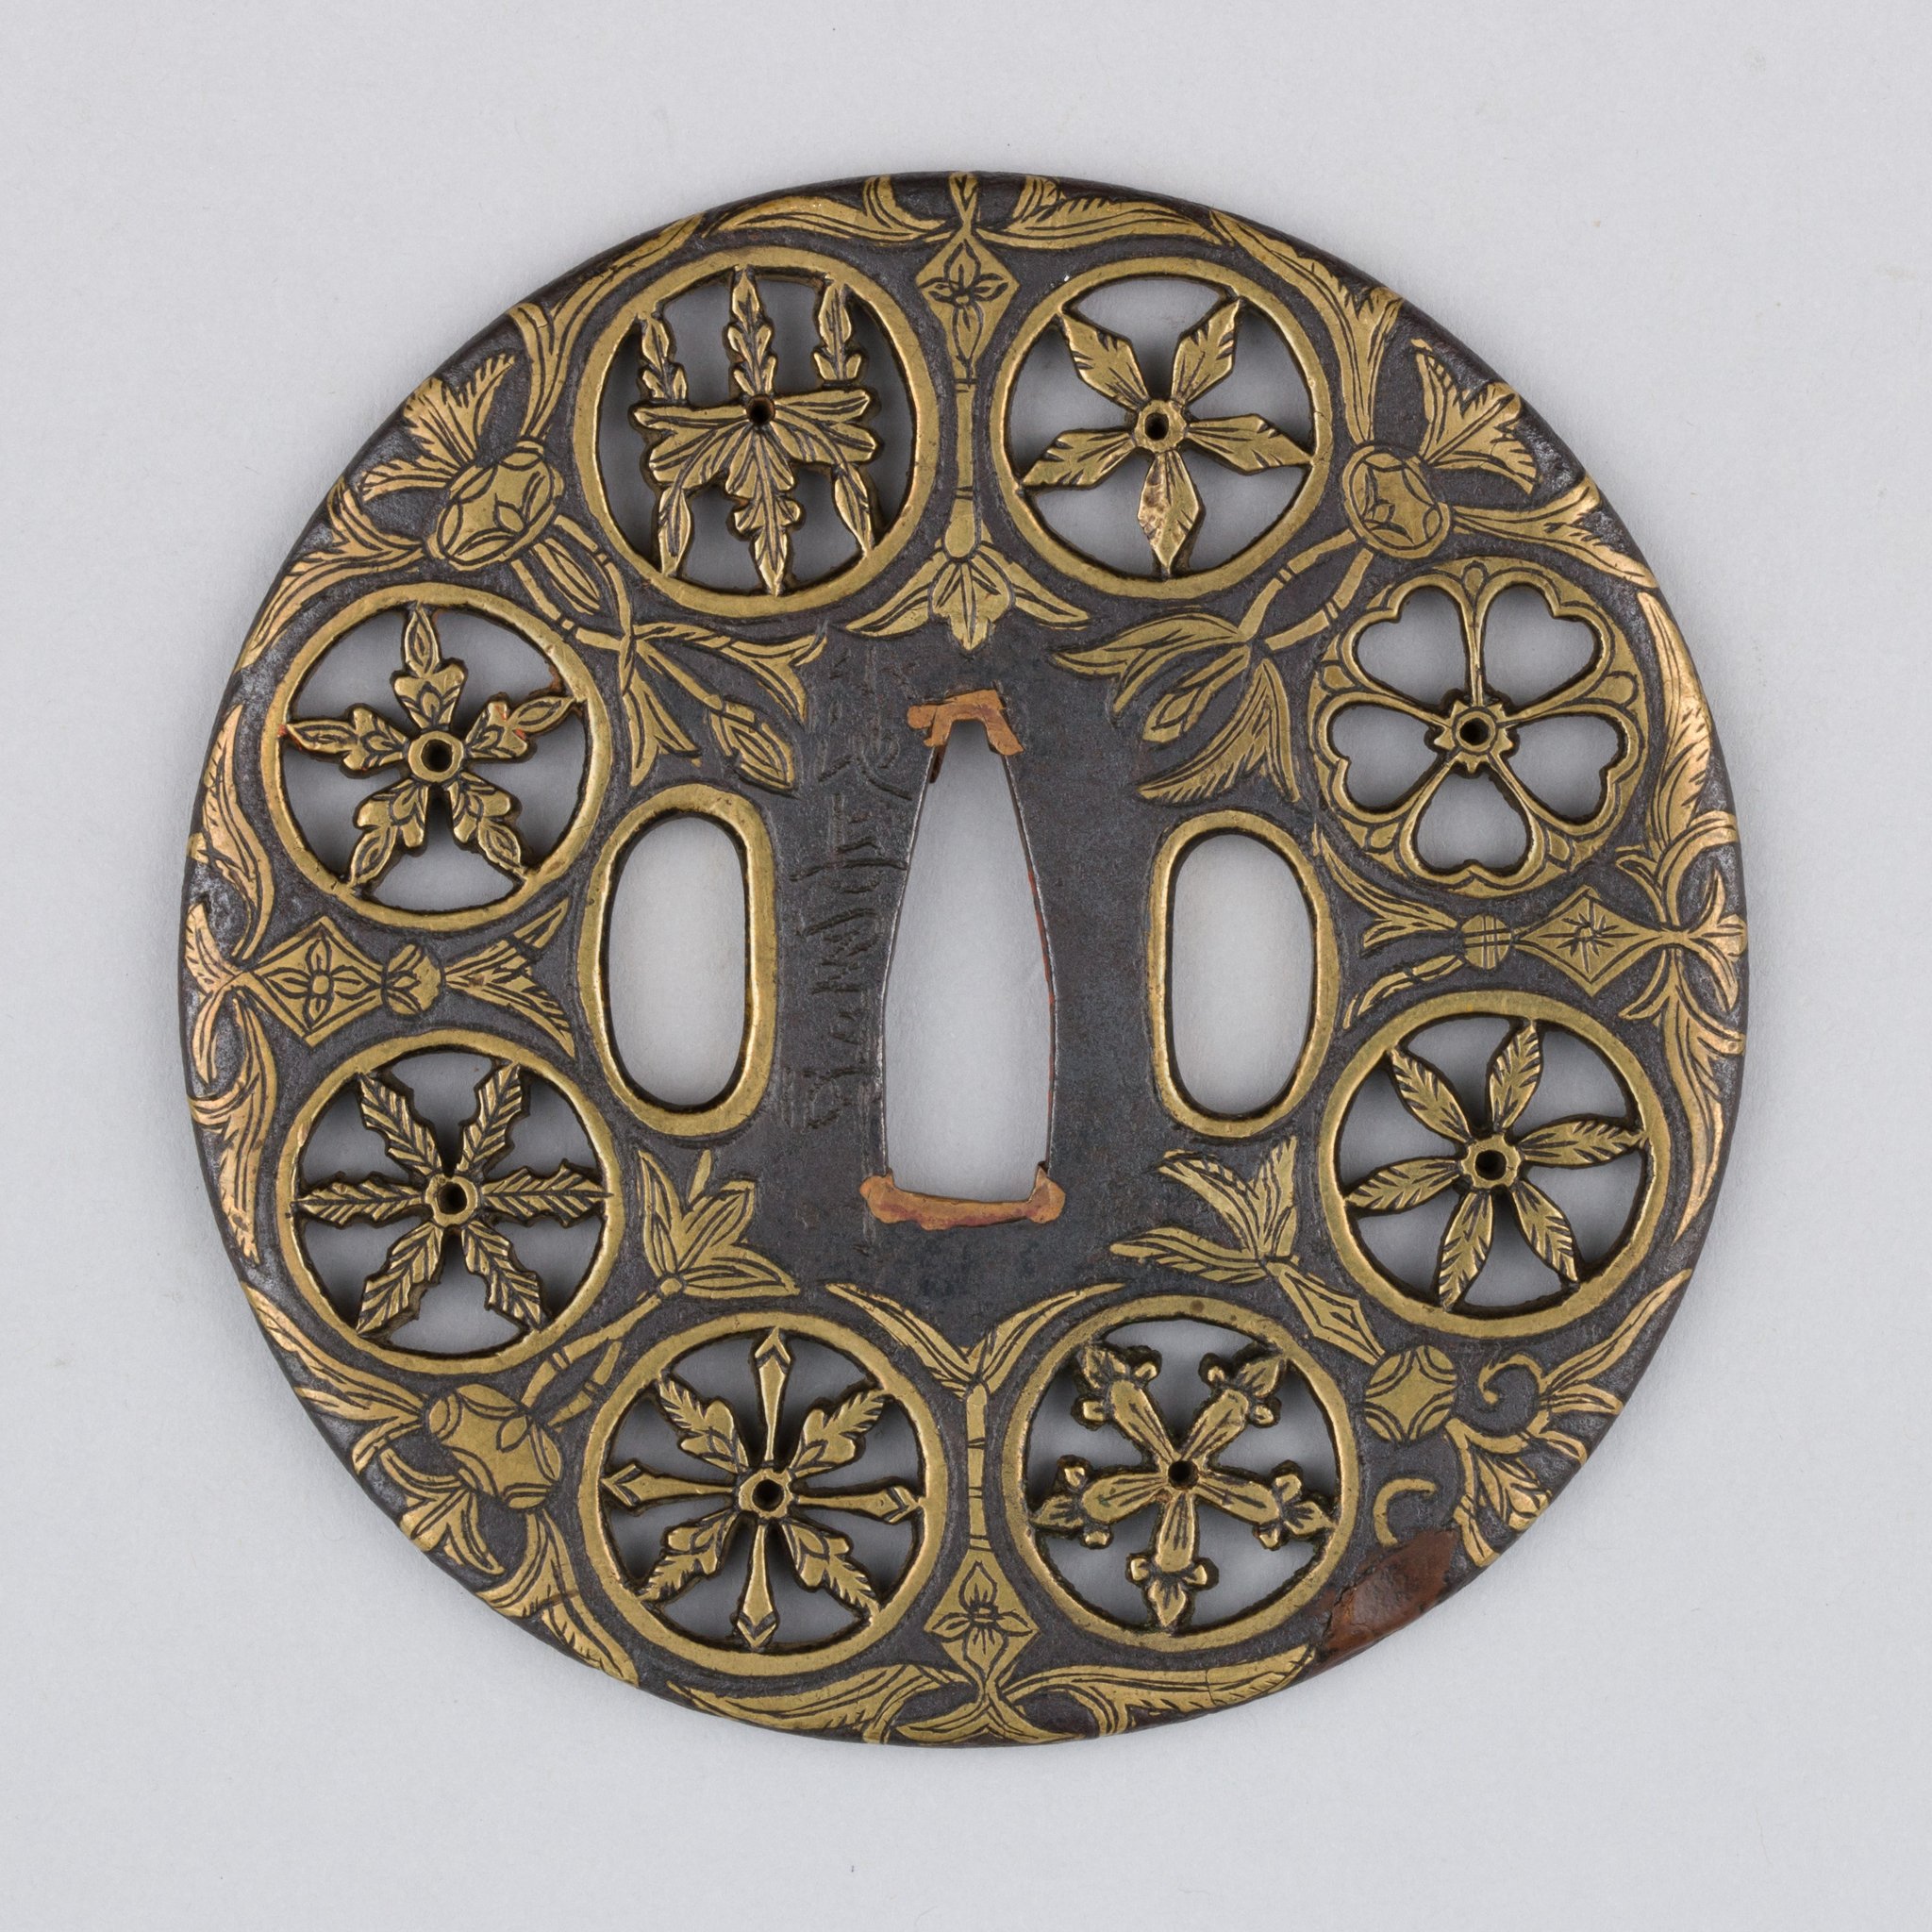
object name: sword guard tsuba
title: Sword guard (Tsuba) Depicting Crests and Arabesques (家紋散唐草文鐔)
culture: japanese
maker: koike izumi no kami naomasa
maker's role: fittings maker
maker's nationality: japanese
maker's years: 1575-1615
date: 1567-1633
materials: brass, copper, iron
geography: japan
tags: flowers